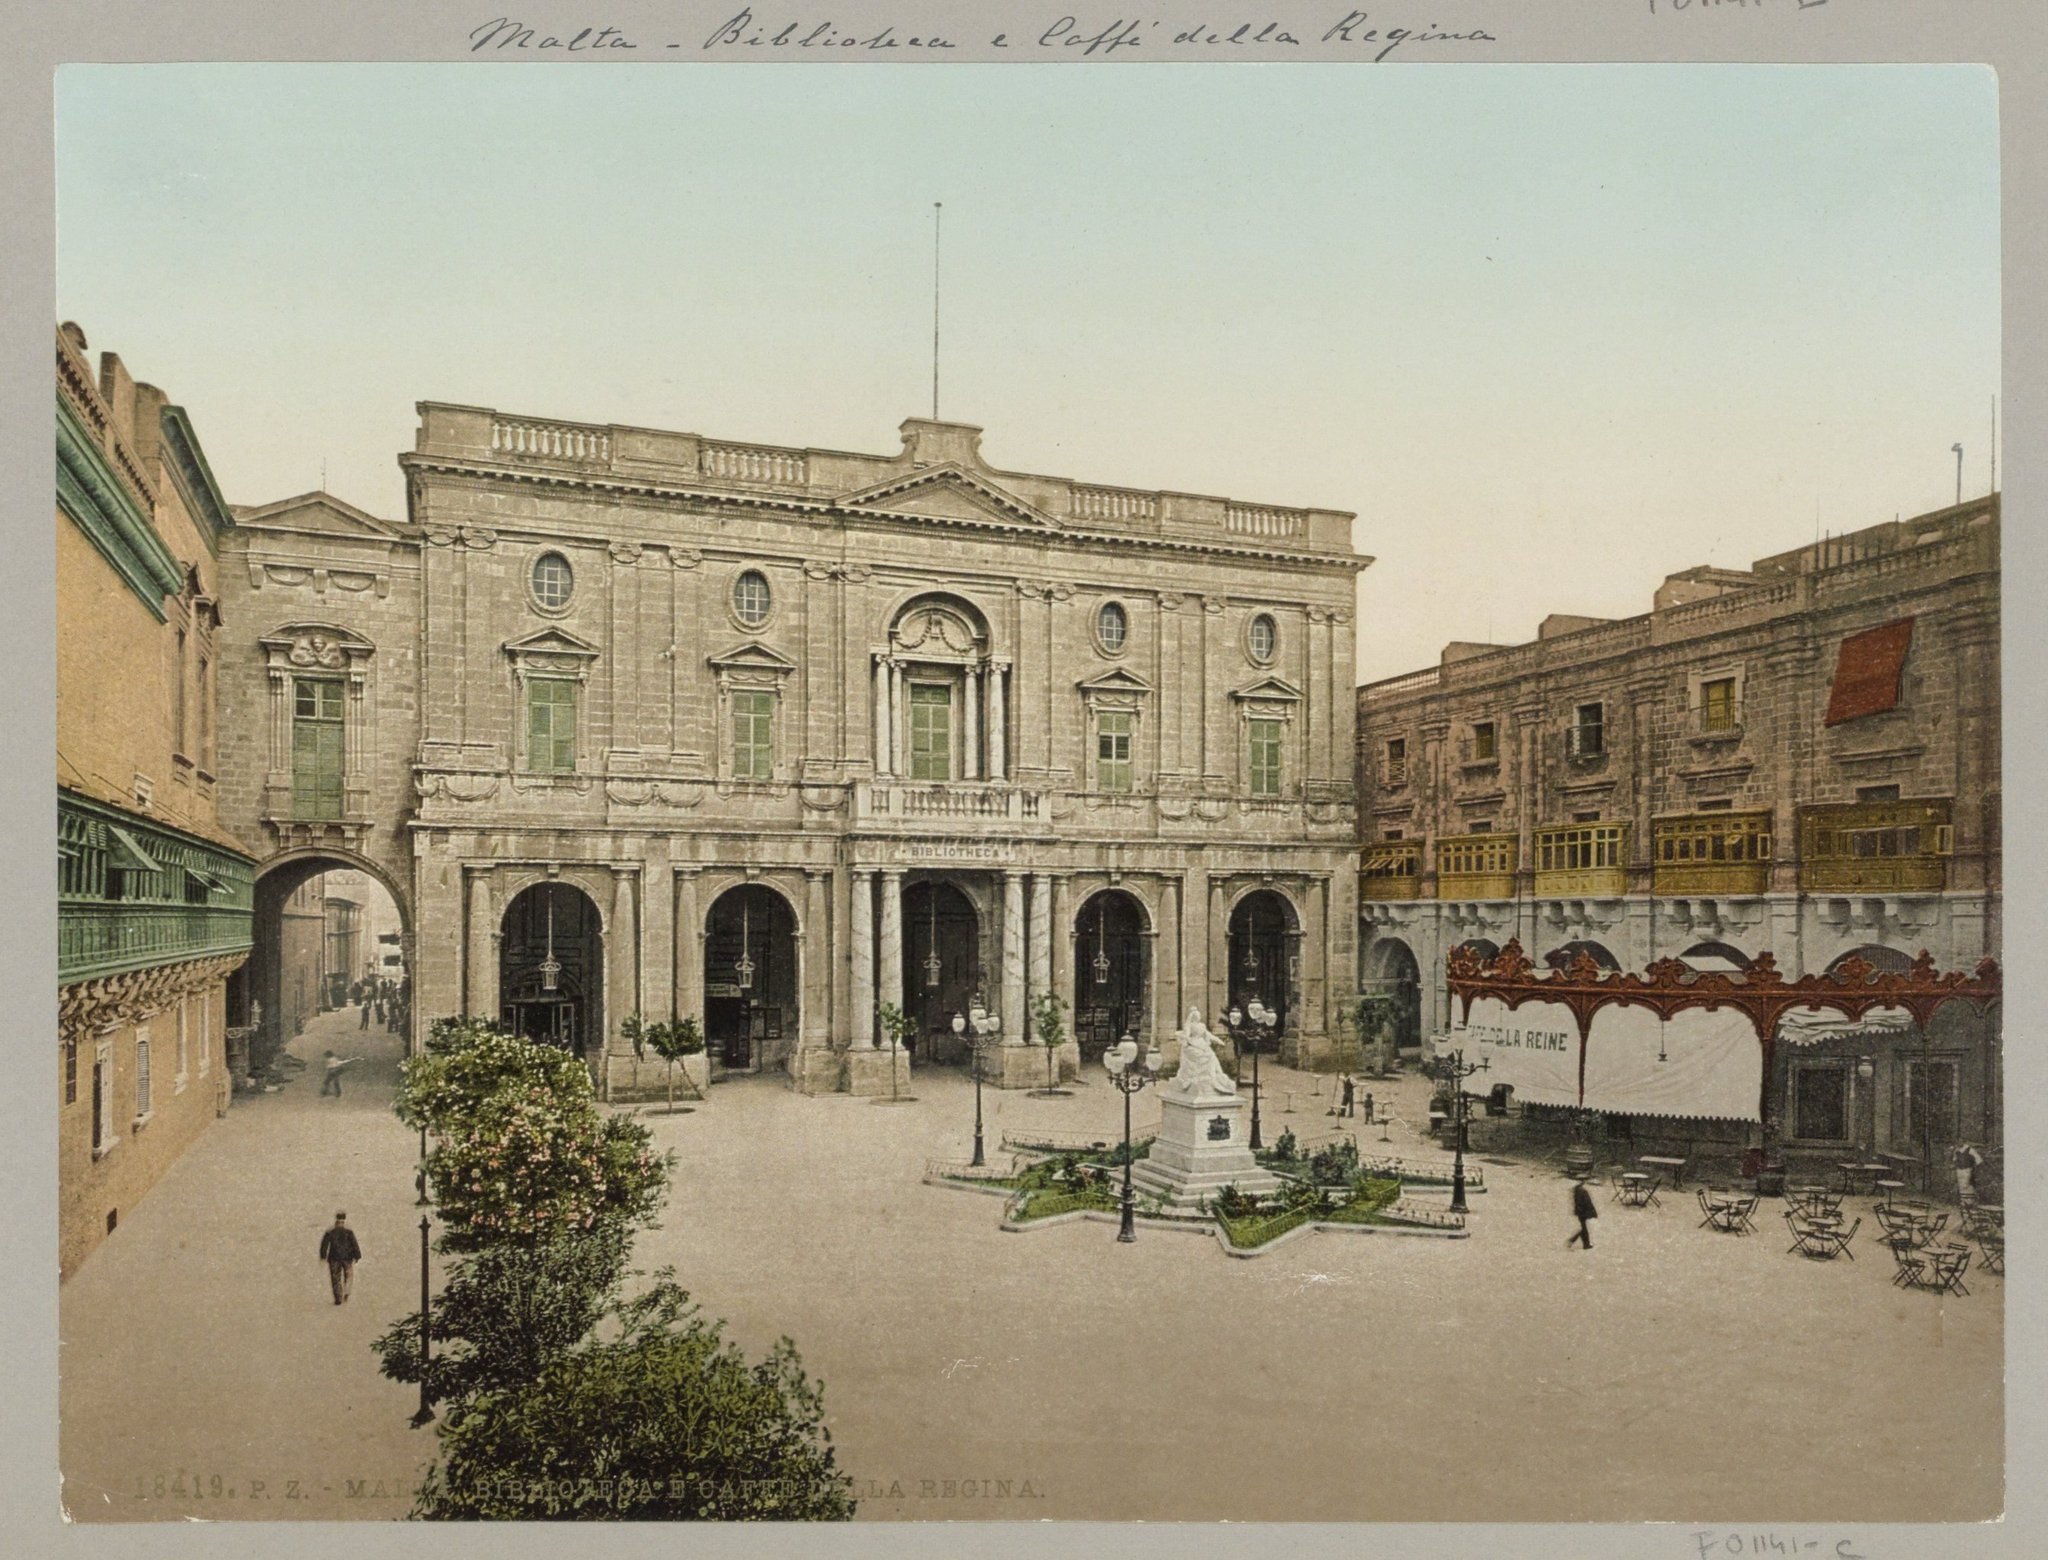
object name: photomechanical print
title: Malta. Biblioteca e caffe della Regina.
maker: Anonymous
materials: paper, photographic process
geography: zurich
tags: public library, hotel, hostelry, inn, square, place, circus, etc. (+ city(-scape) with figures, staffage)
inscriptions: number: ‘18419’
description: Onderdeel van Fotoalbum van een reis door Zuid-Europa en het Midden-Oosten.